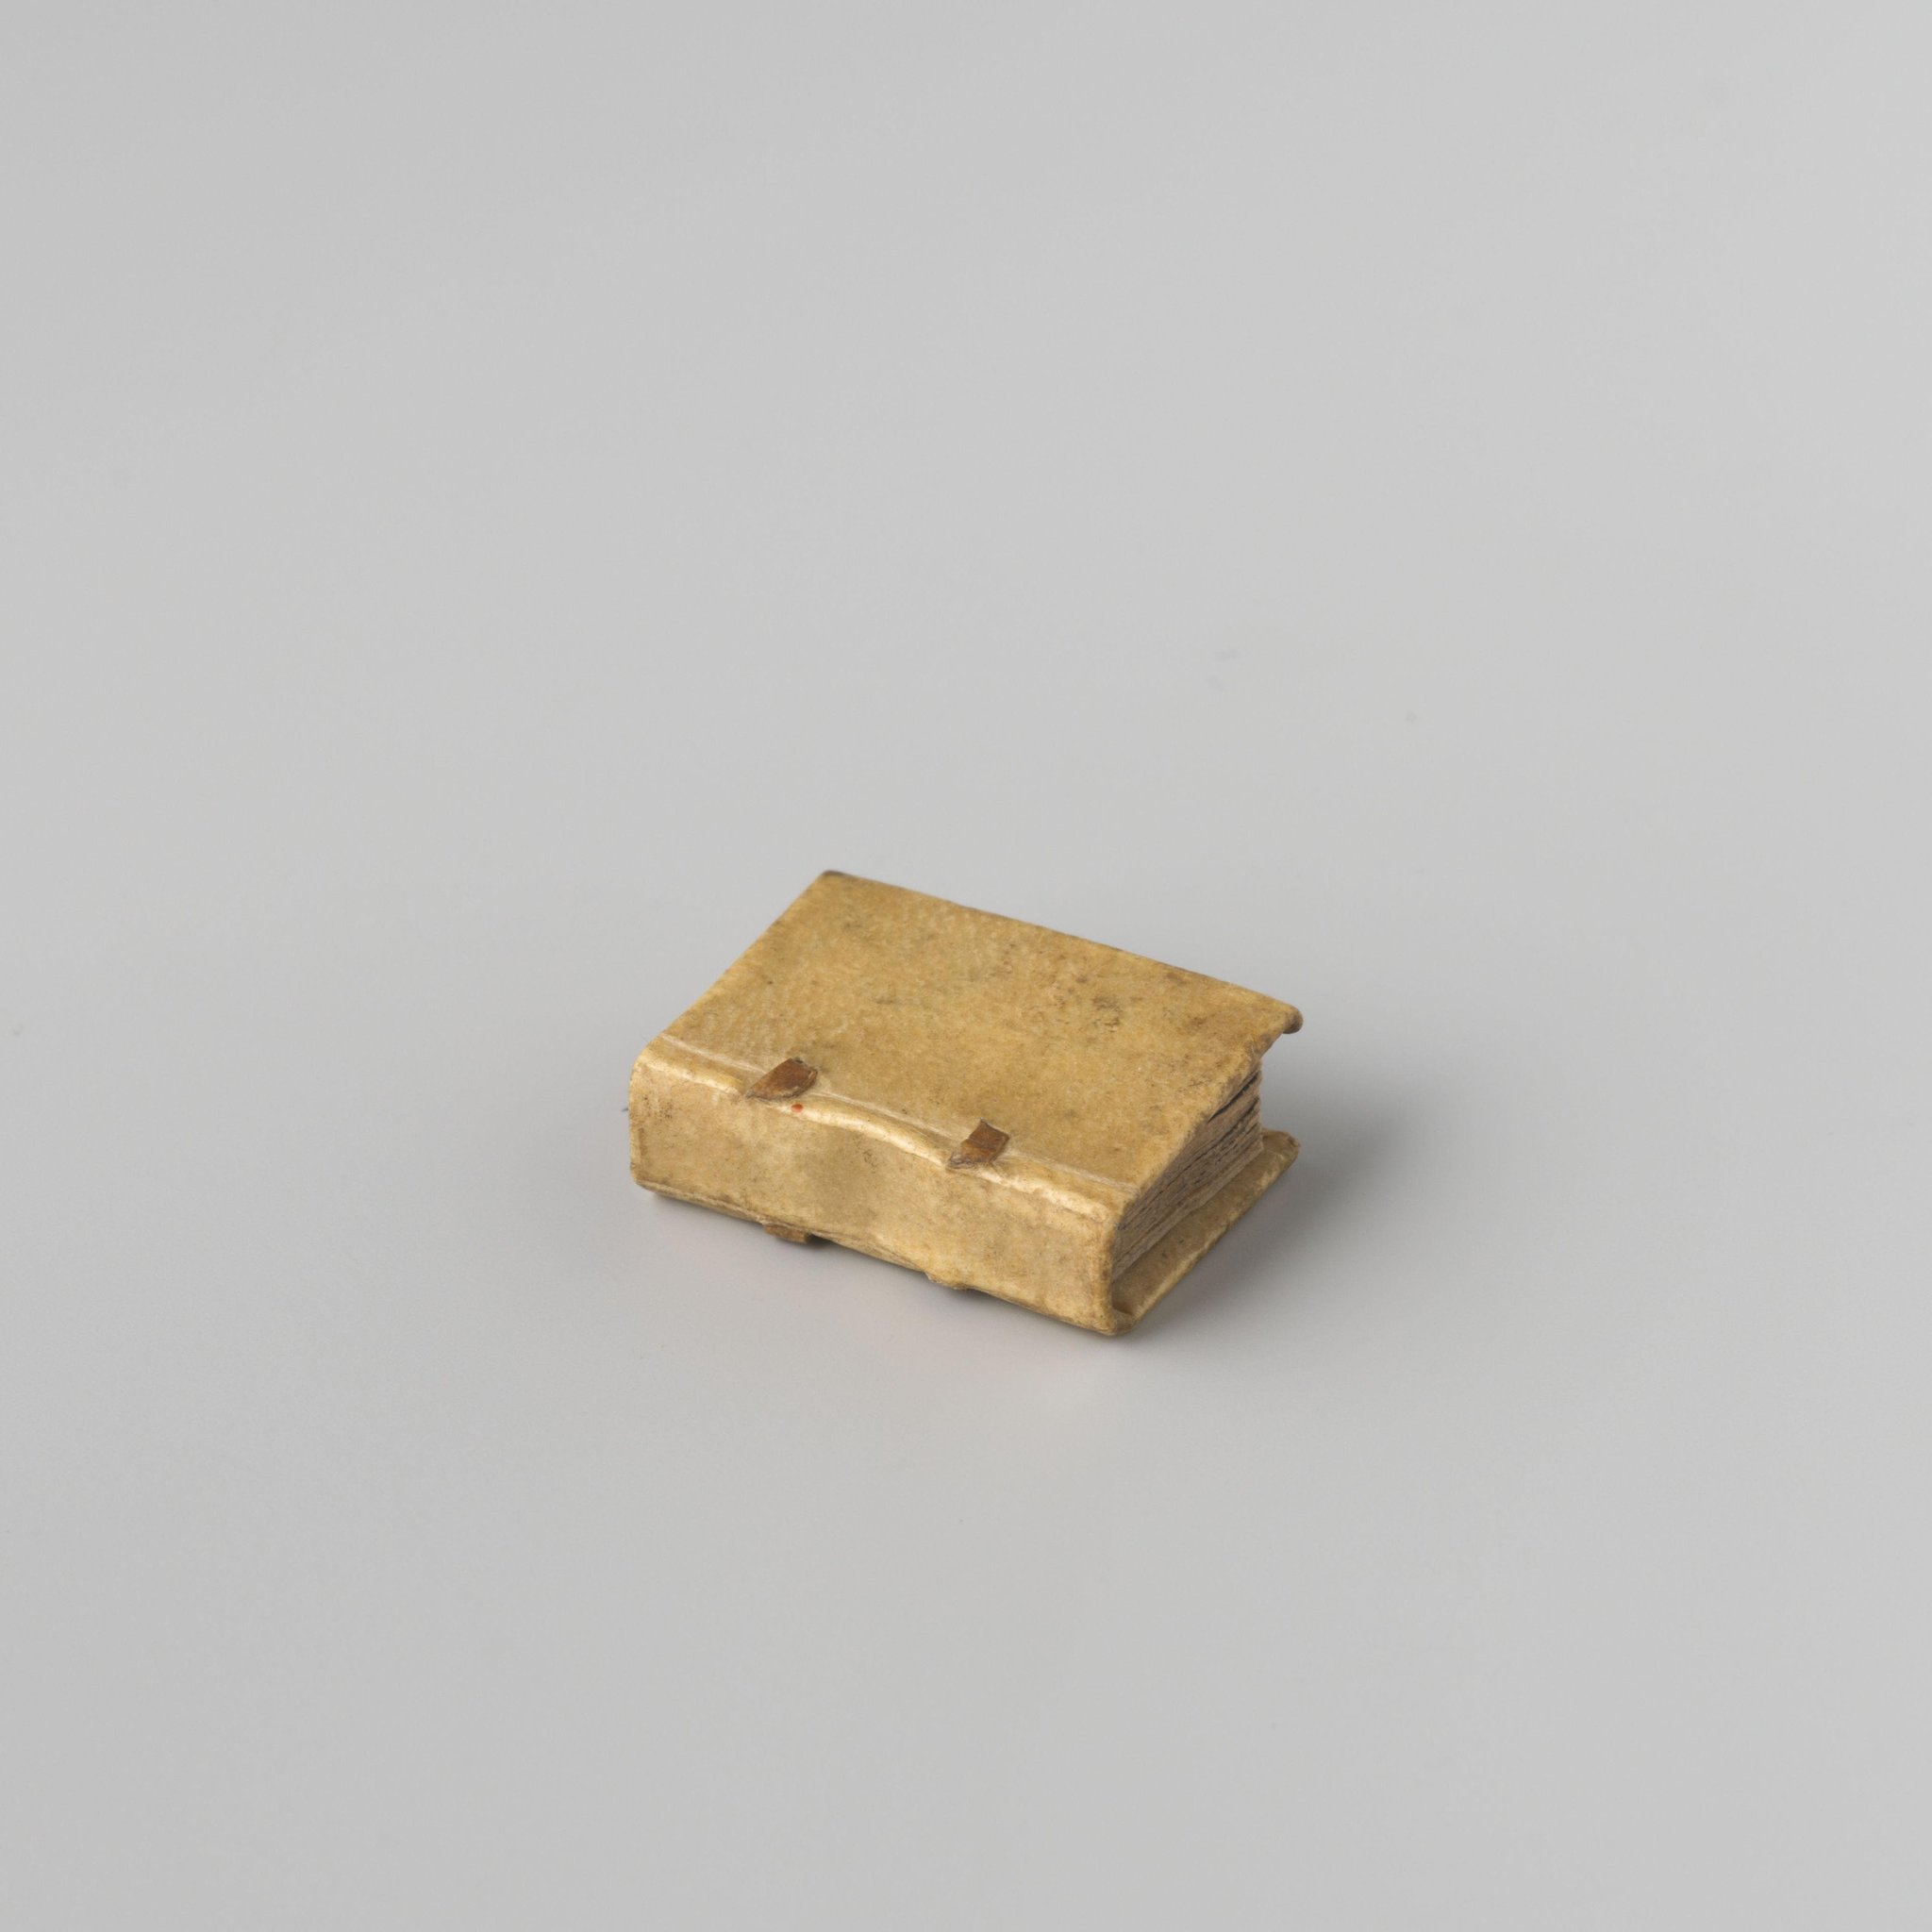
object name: miniature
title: Boek met figuren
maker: Anonymous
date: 1690-1710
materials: paper, parchment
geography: amsterdam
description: Boek met figuren. Ingebonden in blank perkament.